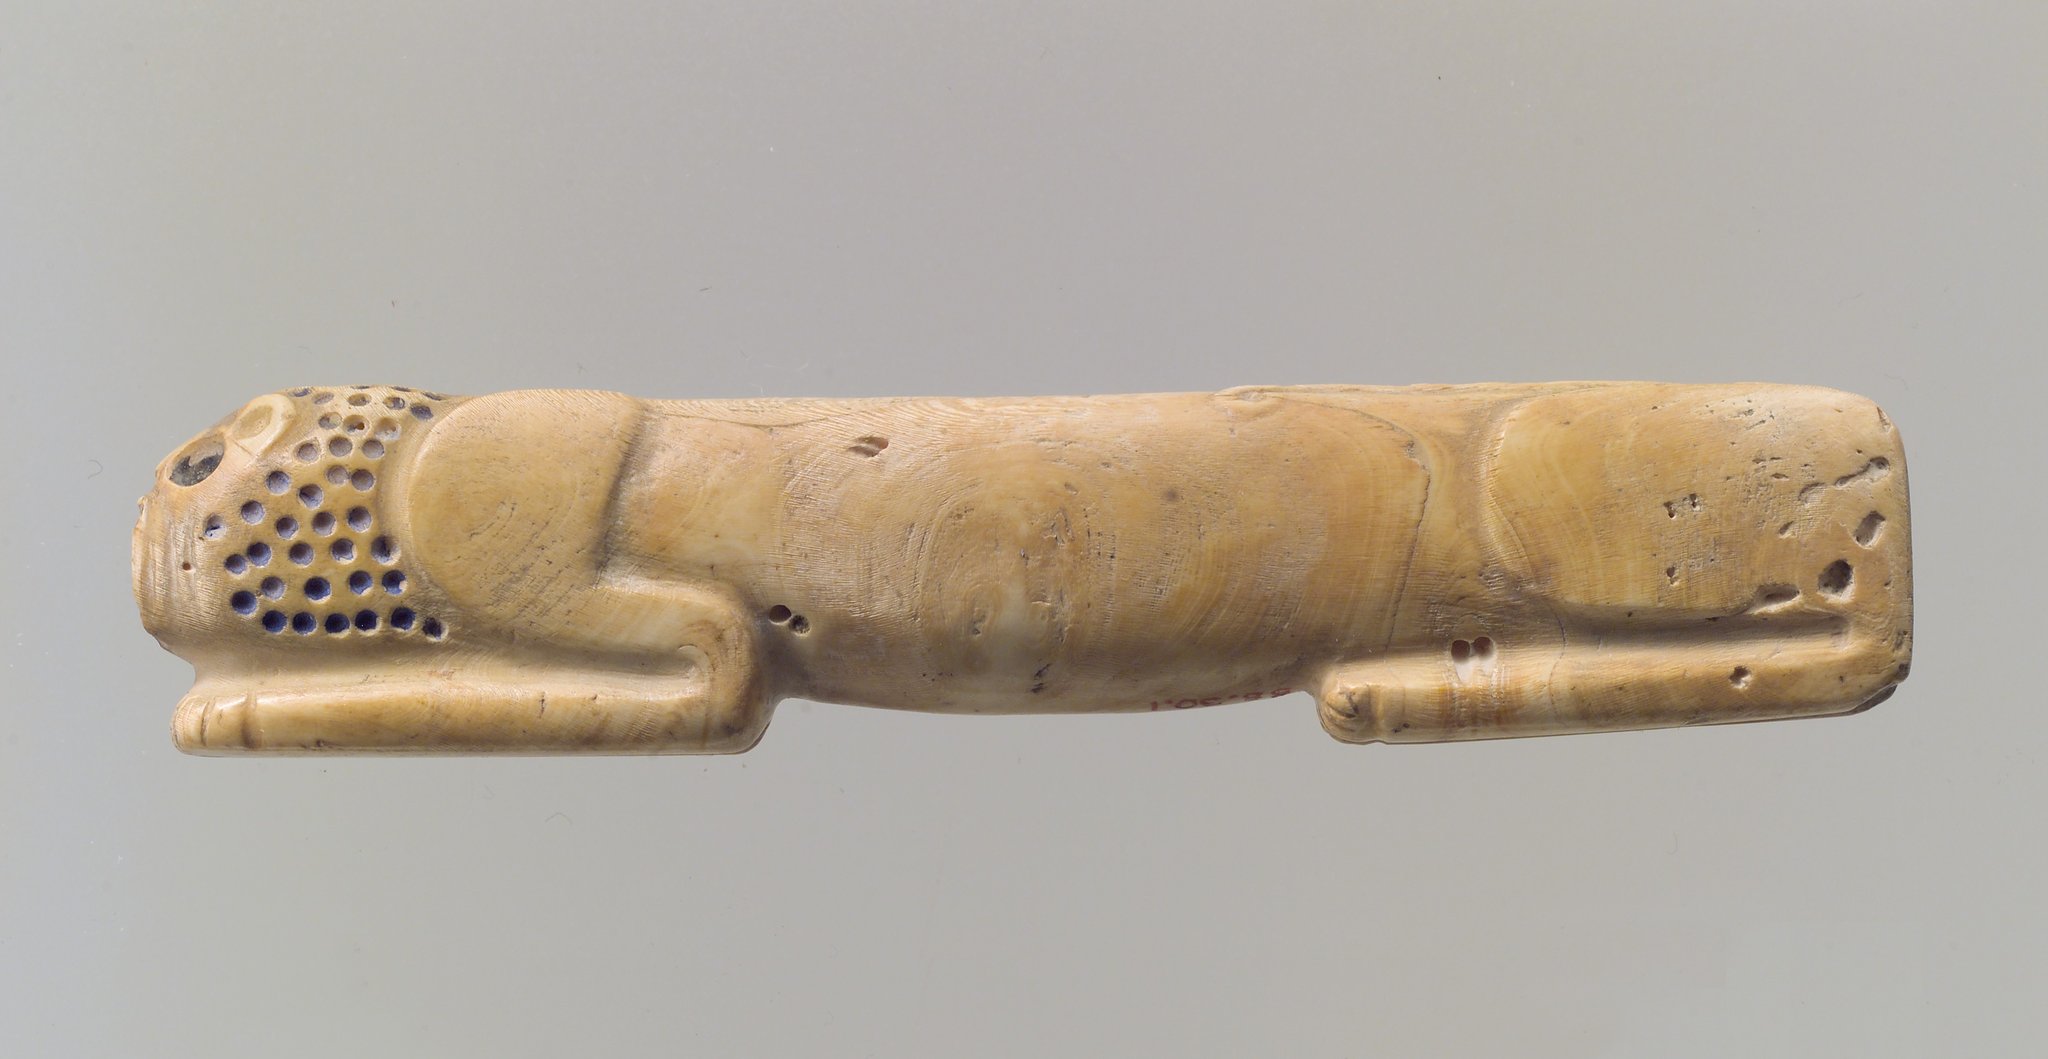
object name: necklace, bead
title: Amulet in the form of a couchant lion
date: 2900-2700 BCE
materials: shell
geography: southern mesopotamia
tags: lions